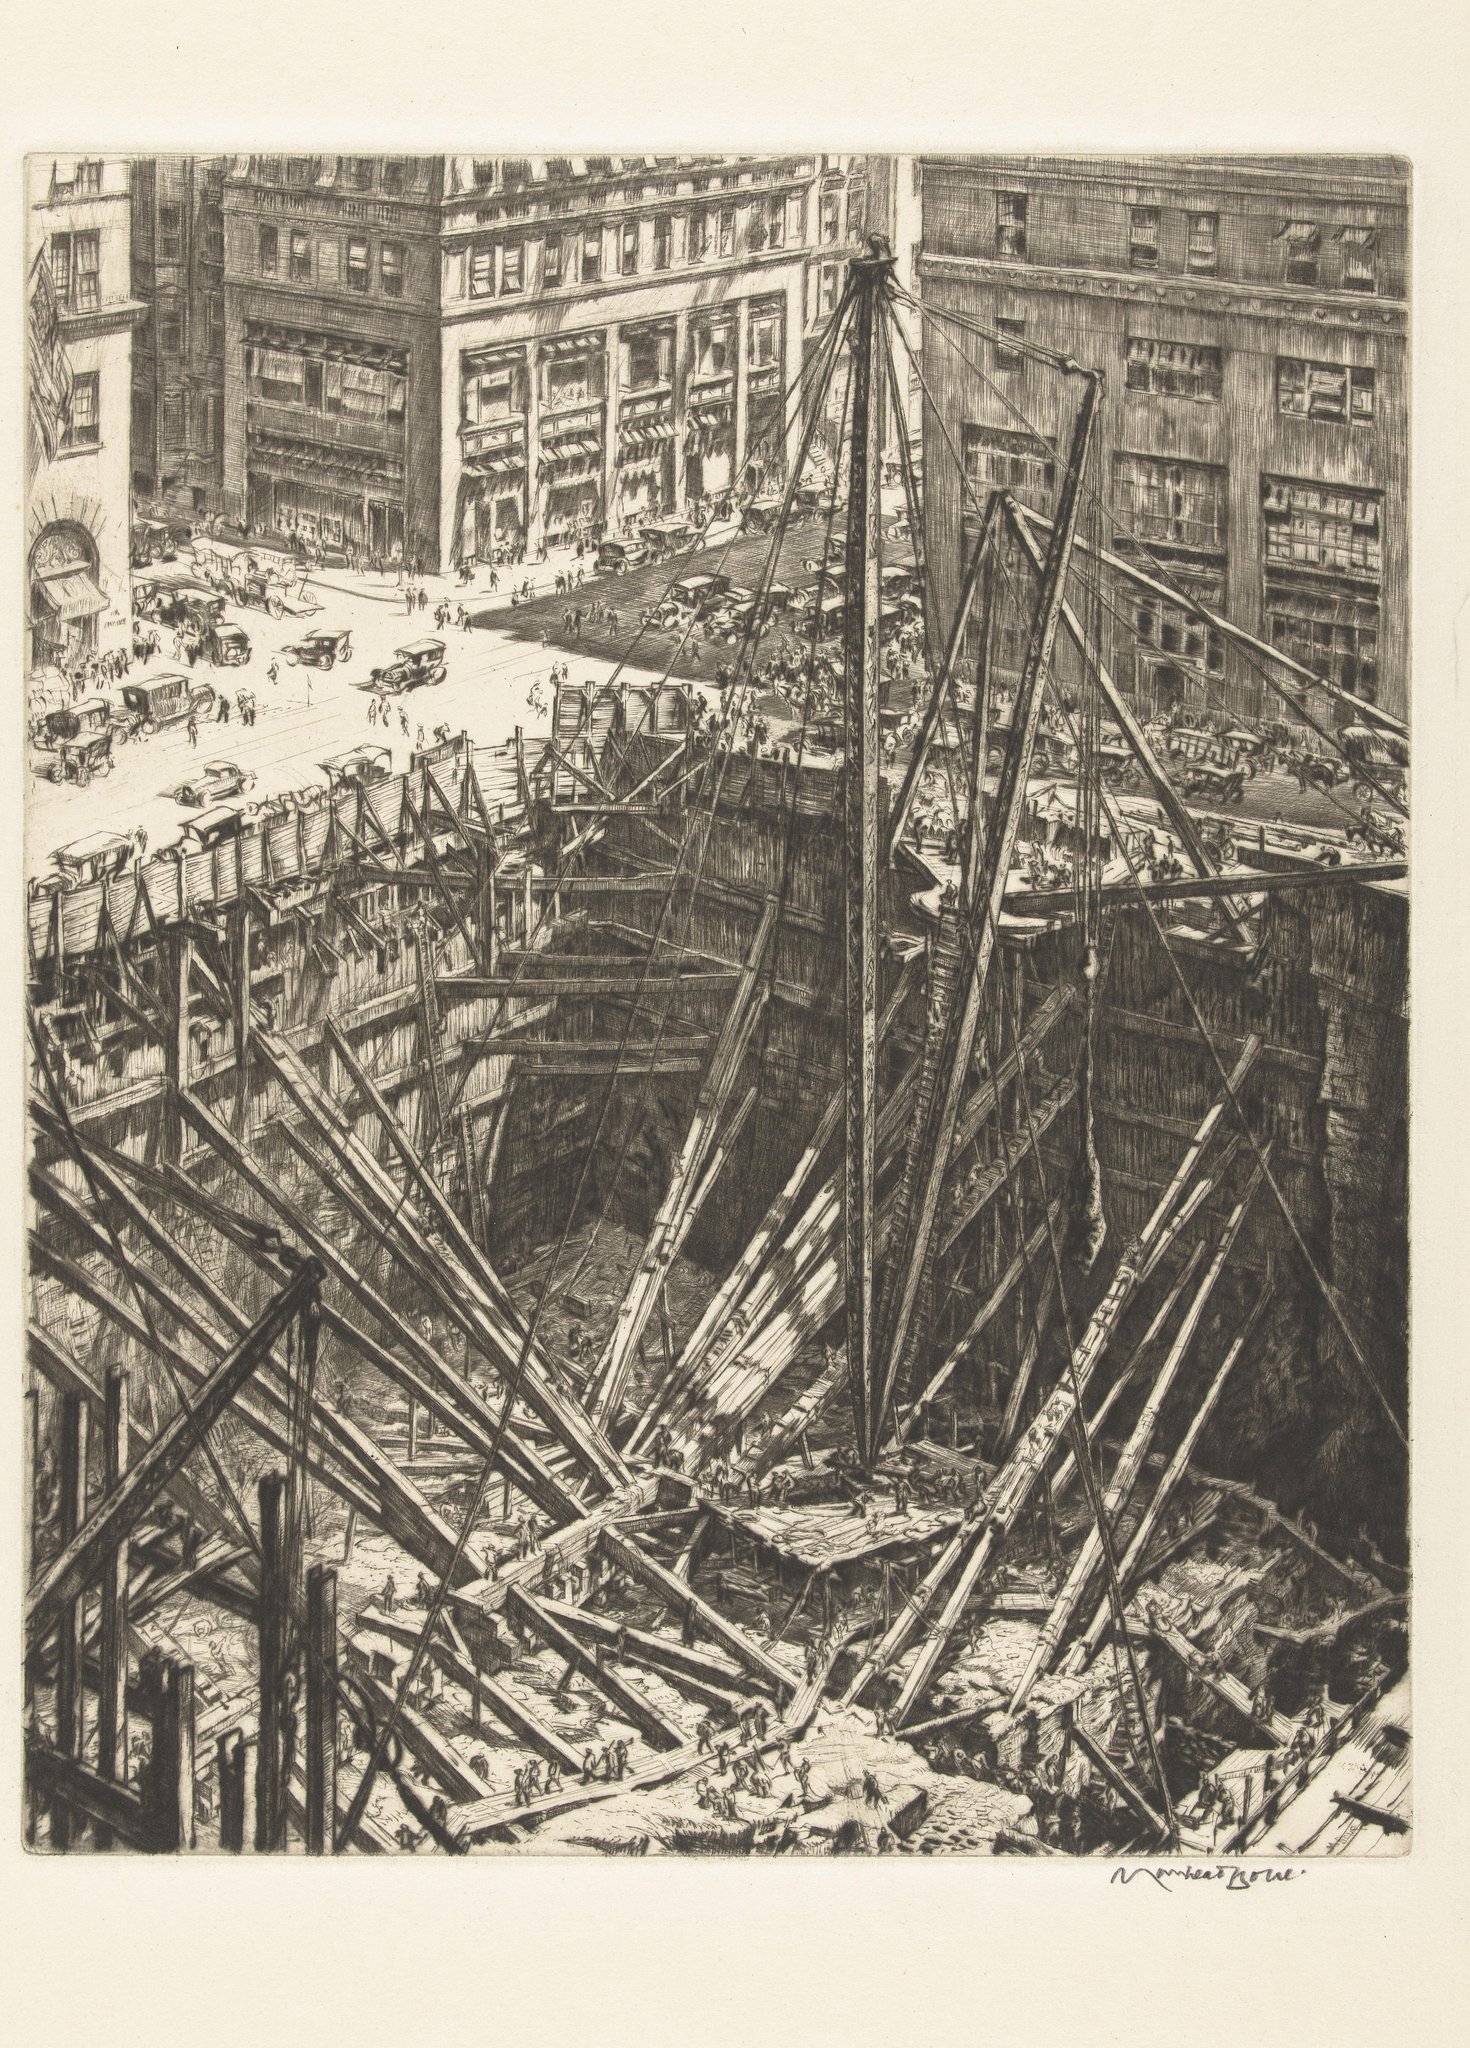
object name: print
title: Manhattan Excavation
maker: muirhead bone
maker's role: artist, print maker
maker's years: 1876-1953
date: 1923-1928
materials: paper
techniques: drypoint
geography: england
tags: building-site, manhattan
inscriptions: signature: ‘Muirhead Bone’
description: Grote bouwput voor de fundering van een nieuw gebouw op Madison Avenue, New York, van bovenaf gezien. Vele werklieden zijn aan het werk.